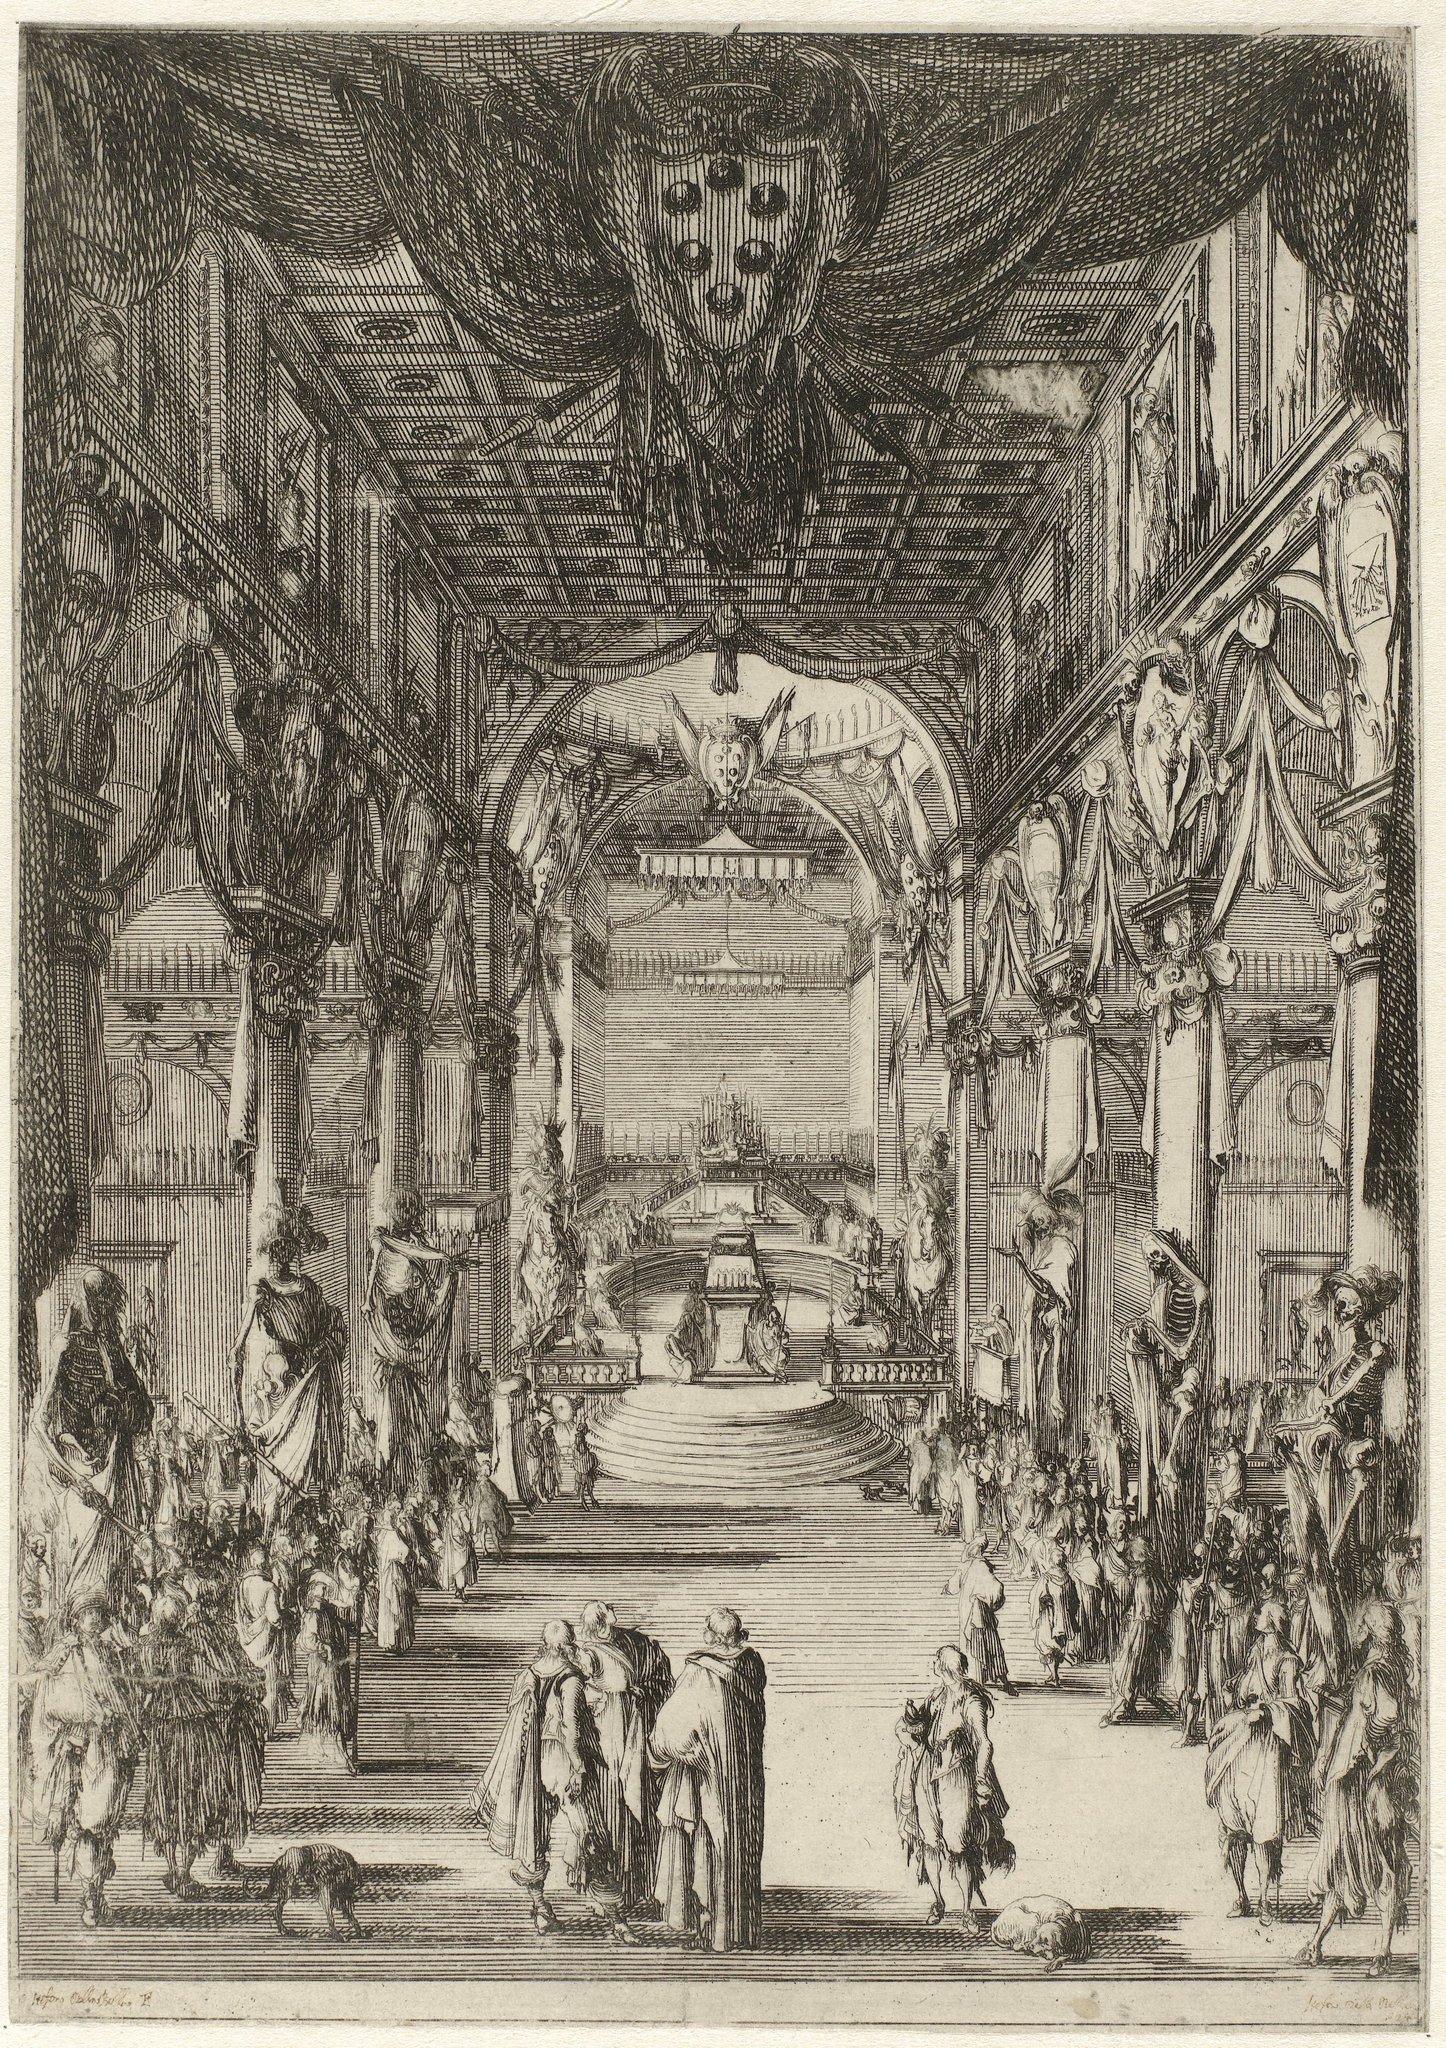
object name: print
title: Begrafenis van Francesco II de' Medici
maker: stefano della bella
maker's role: draughtsman, print maker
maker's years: 1610-1664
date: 1620-1664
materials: ink, paper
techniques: etching, pen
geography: italy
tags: funerary ceremonial, public funeral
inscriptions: collector's mark: Lugt 2228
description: De begrafenis van Francesco II de' Medici in de San Lorenzo in Florence. Aan het plafond een groot wapenschild de familie de' Medici. Langs het schip zijn verschillende aangeklede skeletten tegen pilaren geplaatst ter decoratie. Tekening van twee figuren op verso.